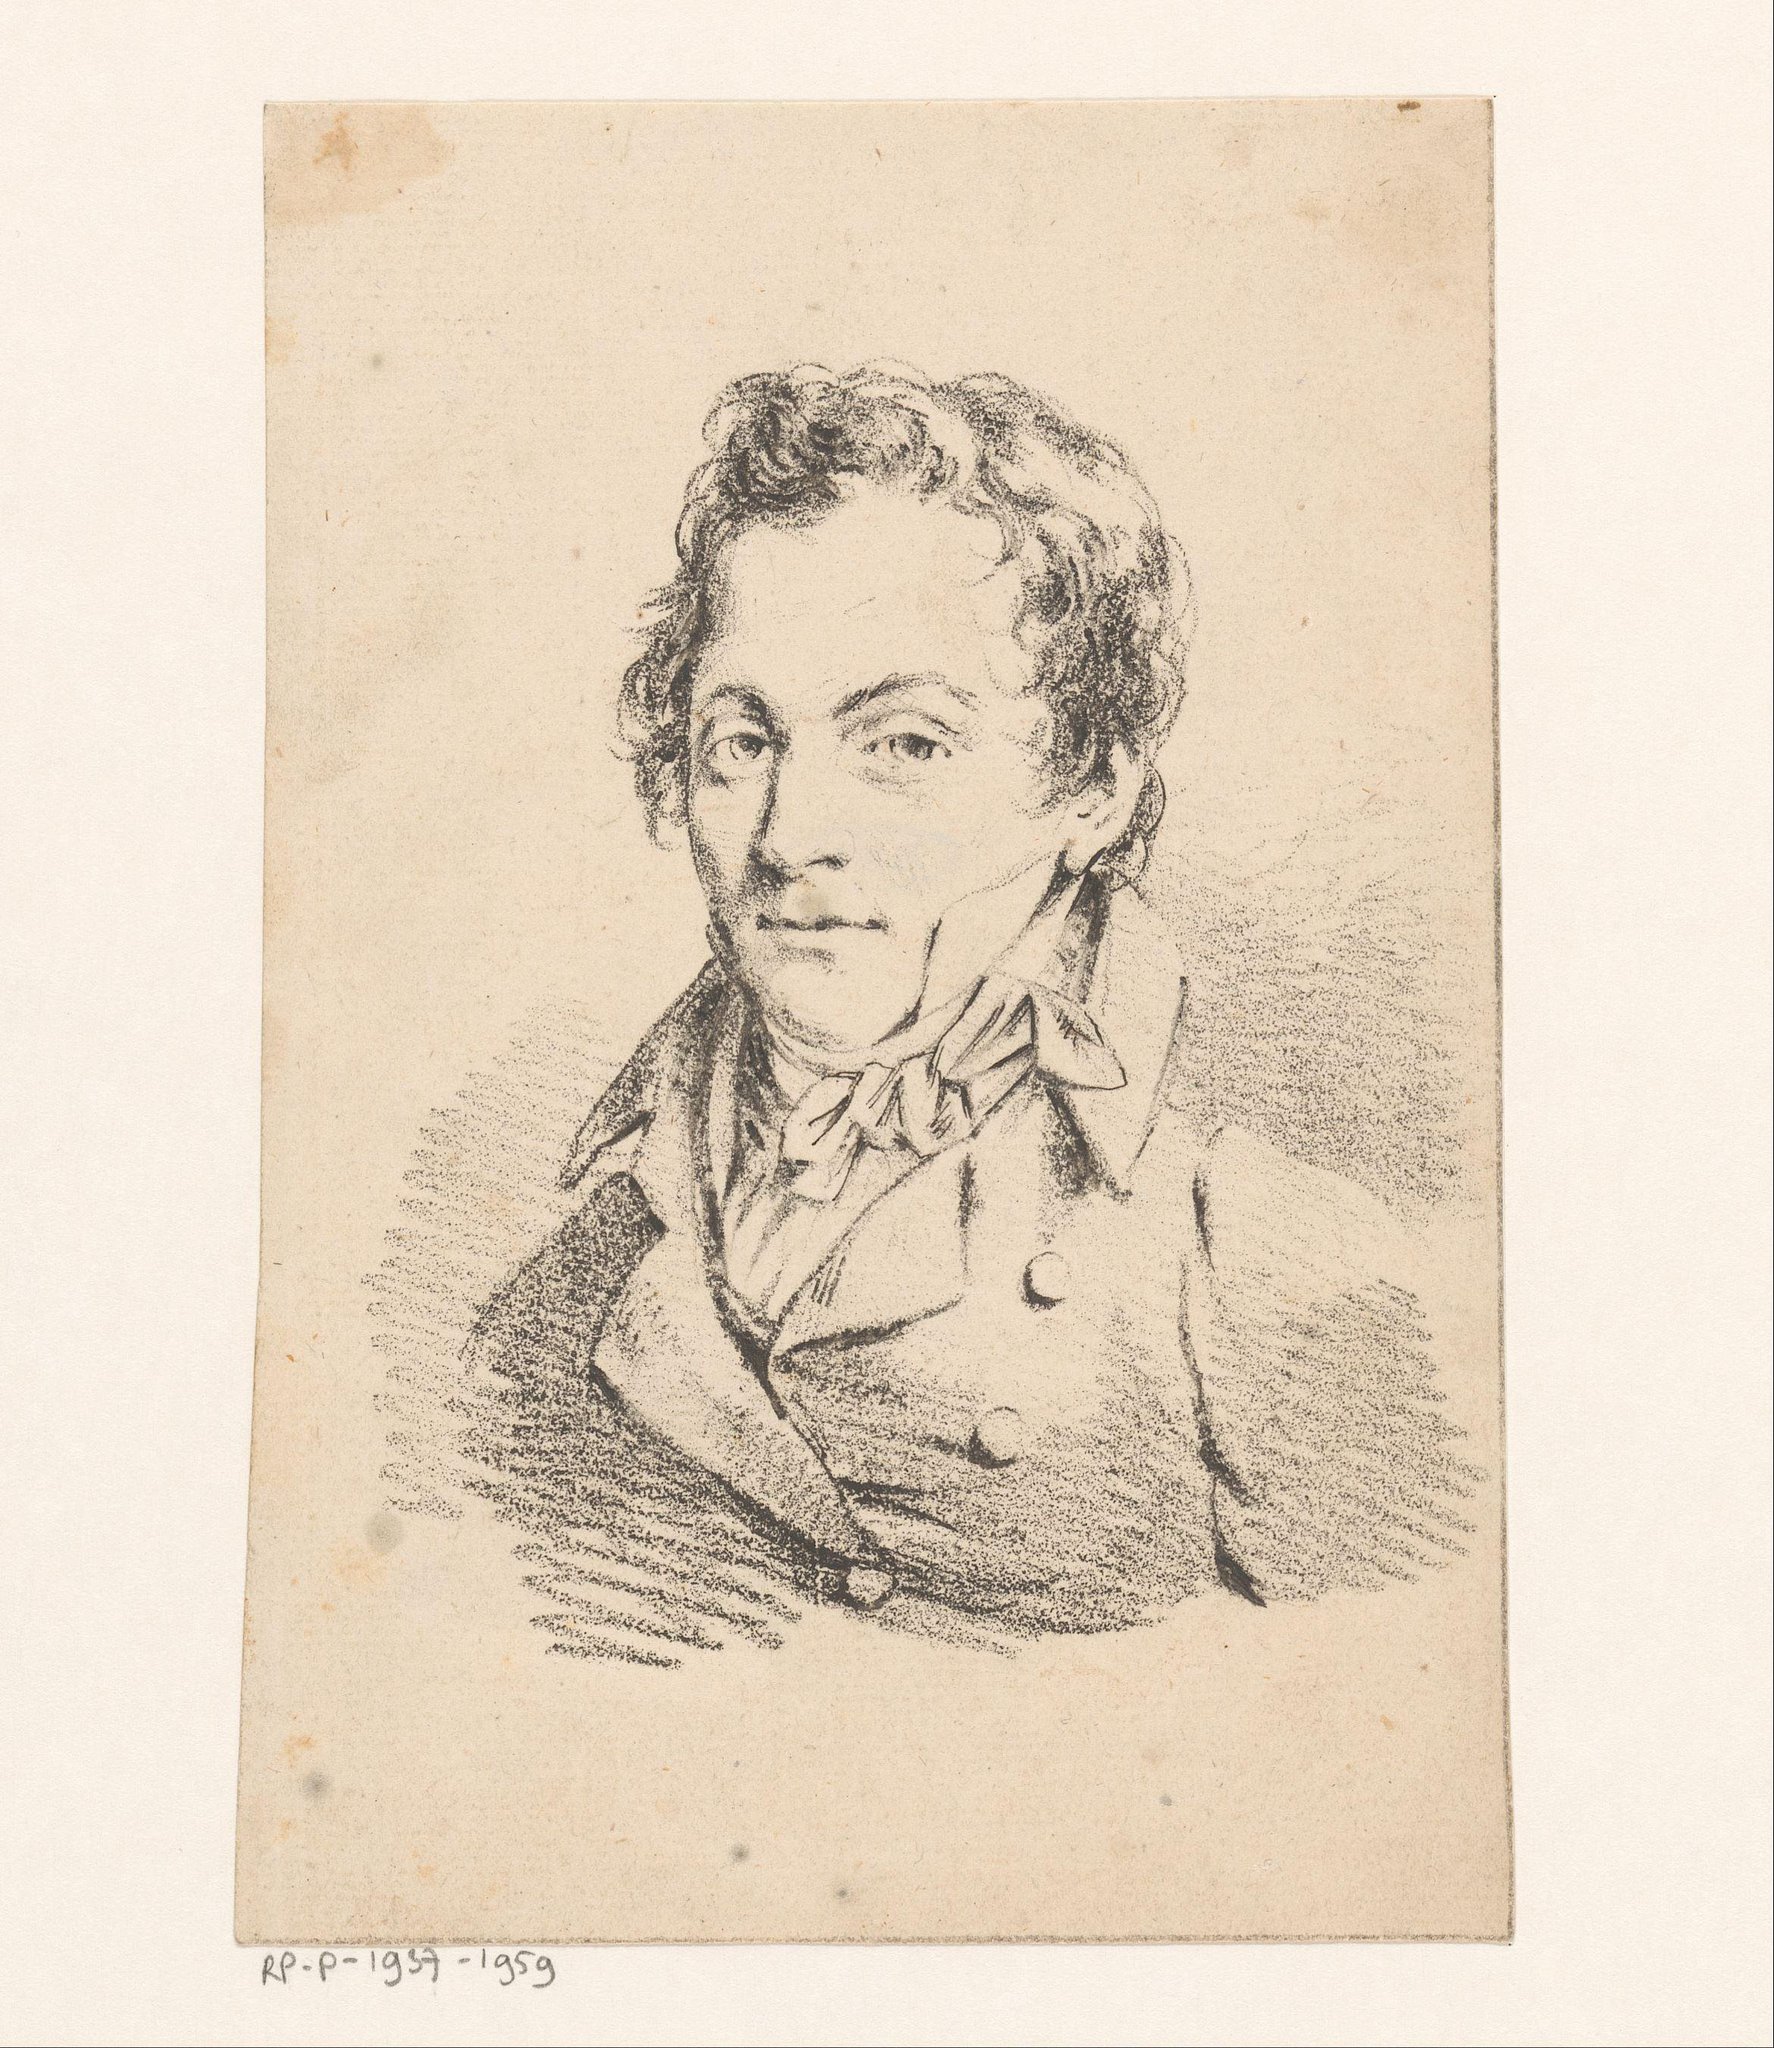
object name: print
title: Mansportret, mogelijk een zelfportret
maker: jean augustin daiwaille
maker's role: draughtsman, print maker, printer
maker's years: 1786-1850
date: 1809-1850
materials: paper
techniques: lithograph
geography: amsterdam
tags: historical persons (+ head (and shoulders) (portrait))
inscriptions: collector's mark: Lugt 2760, collector's mark: Lugt 2228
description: De man draagt een hoge opstaande kraag en een gestrikte das.